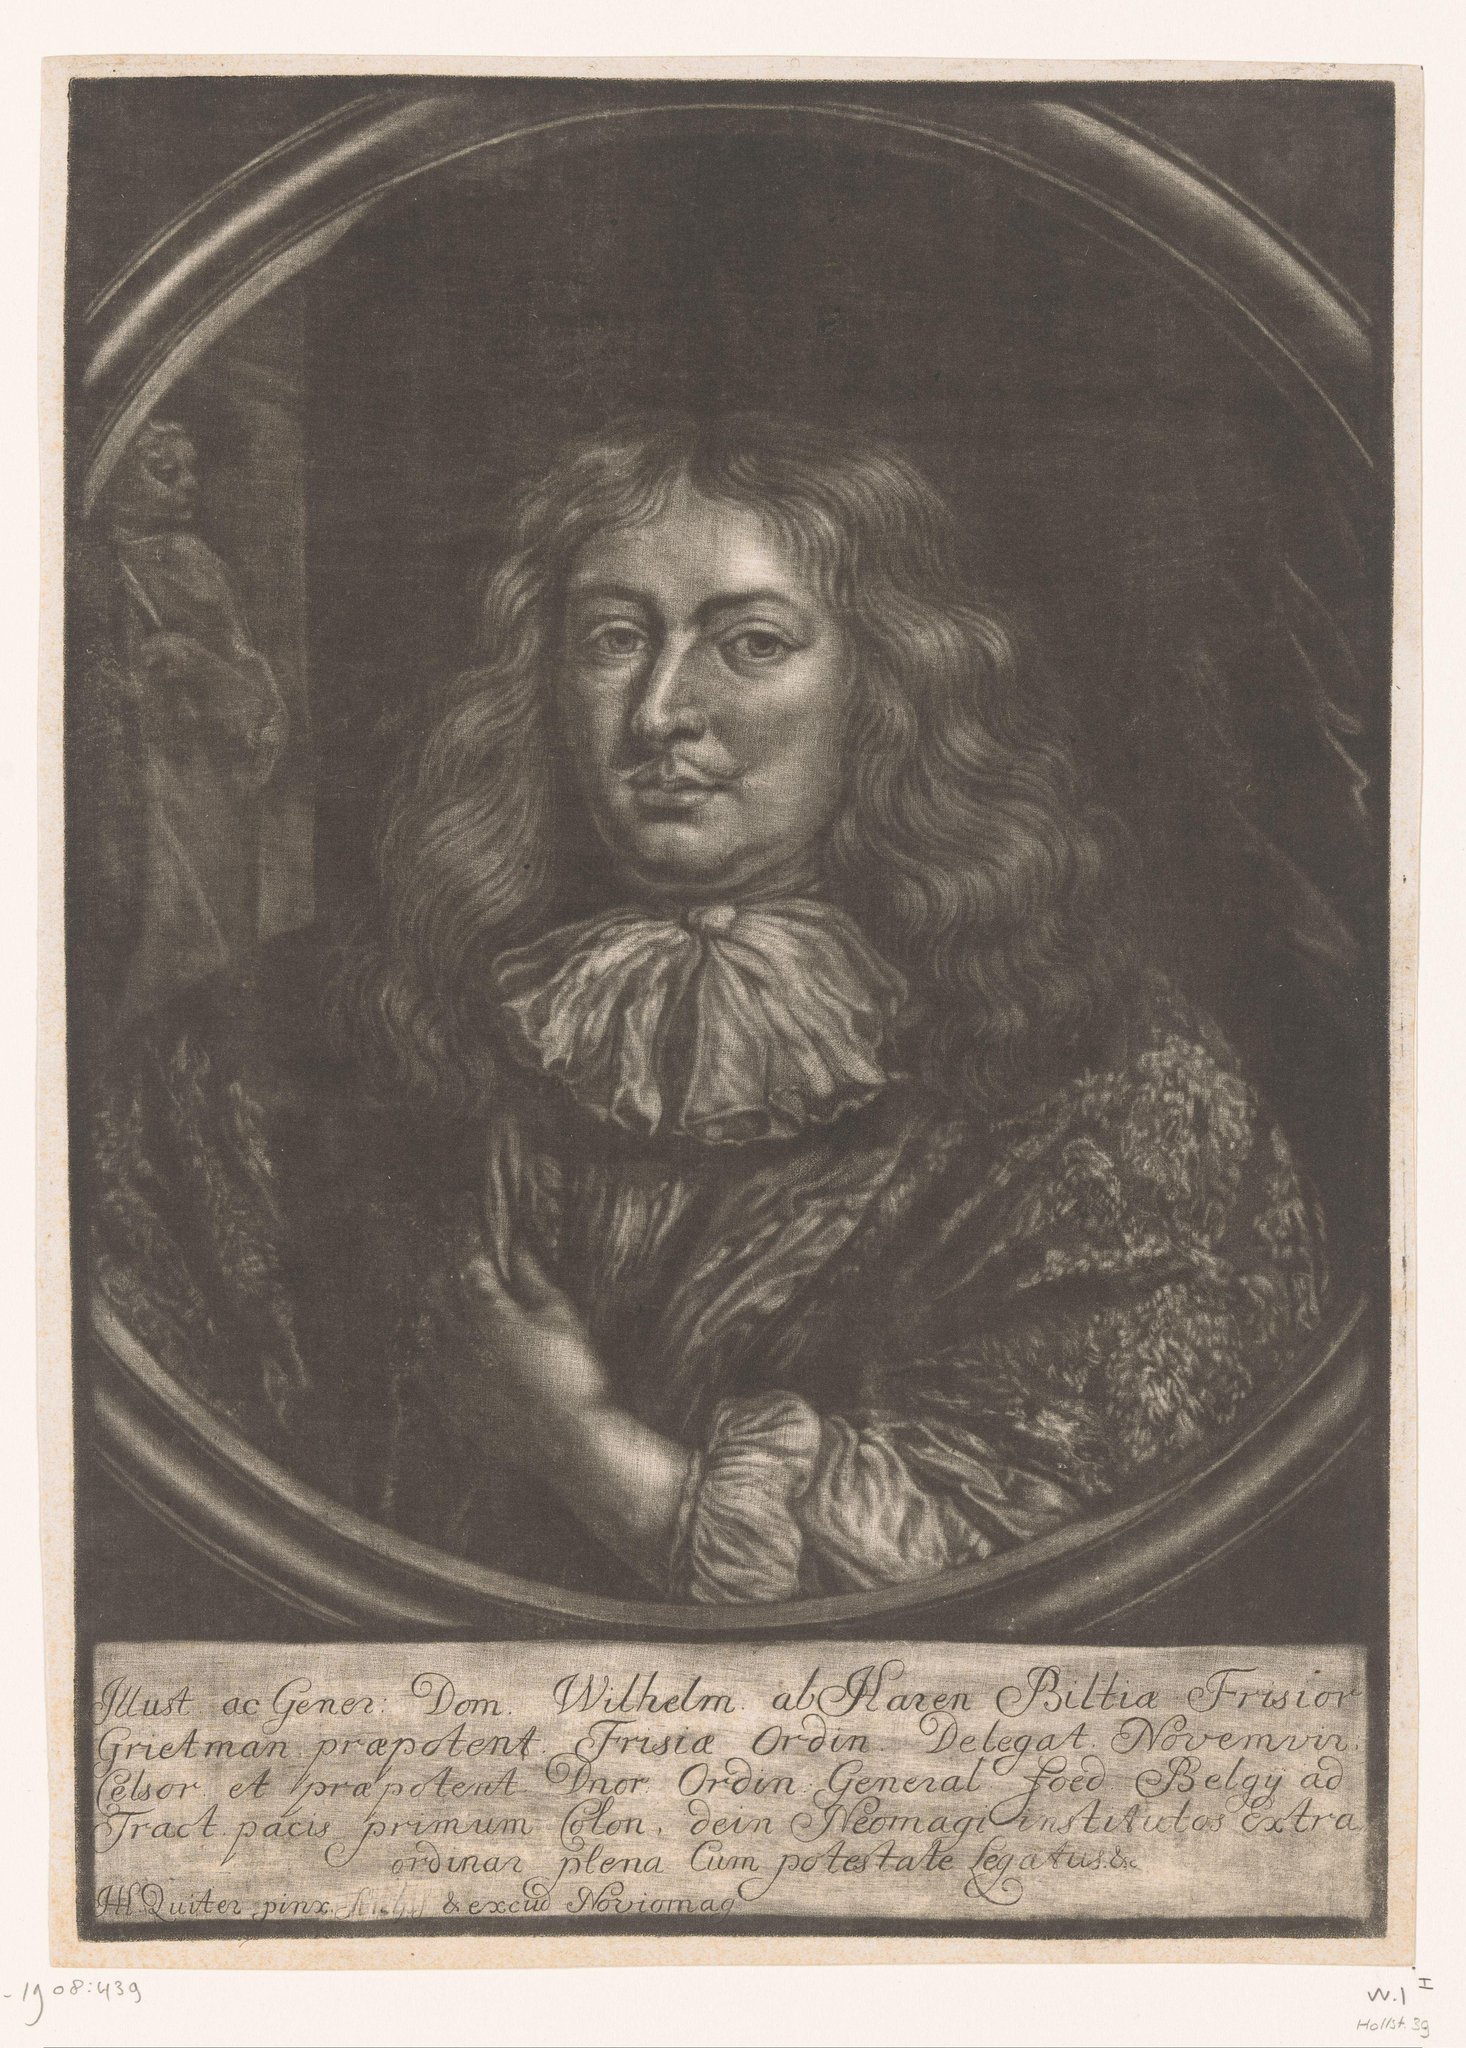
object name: print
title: Portret van Willem van Haren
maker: herman hendrik de quiter (i)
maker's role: painter, print maker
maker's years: 1627-1708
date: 1679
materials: paper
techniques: mezzotint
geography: nijmegen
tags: historical persons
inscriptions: collector's mark: Lugt 2228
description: Prent voor het eerst gebruikt in: Quiter, Hermann Hendrik. Icones legatorum (...). Nijmegen: s.n., 1679.